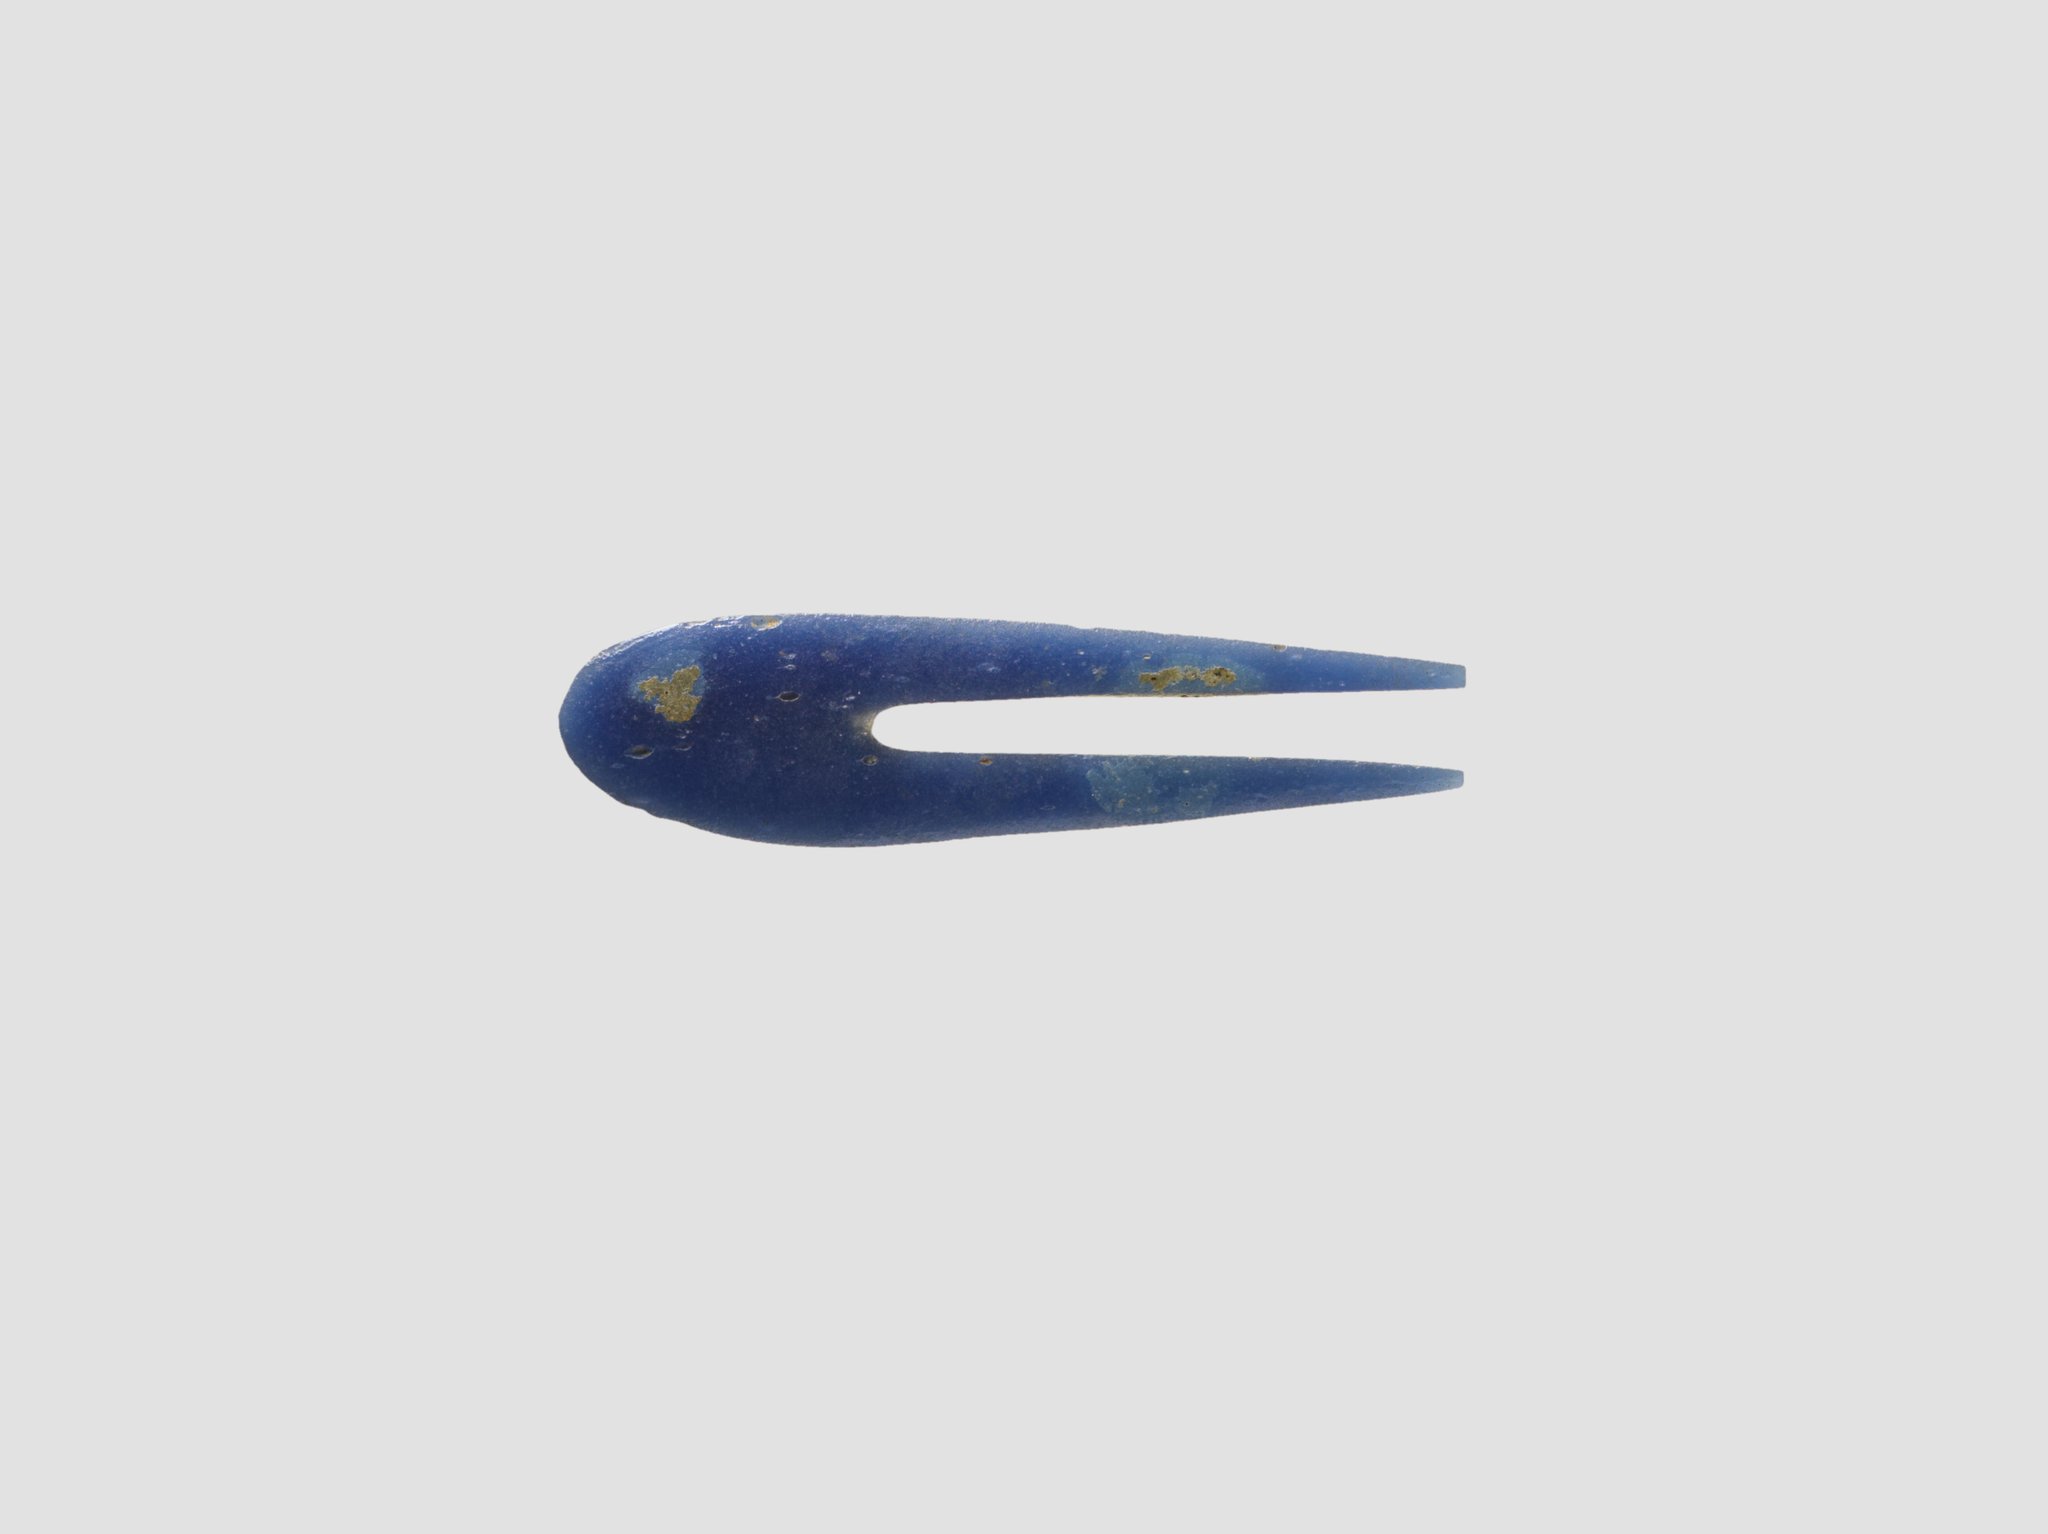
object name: inlay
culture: assyrian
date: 800-601 BCE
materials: glass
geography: mesopotamia